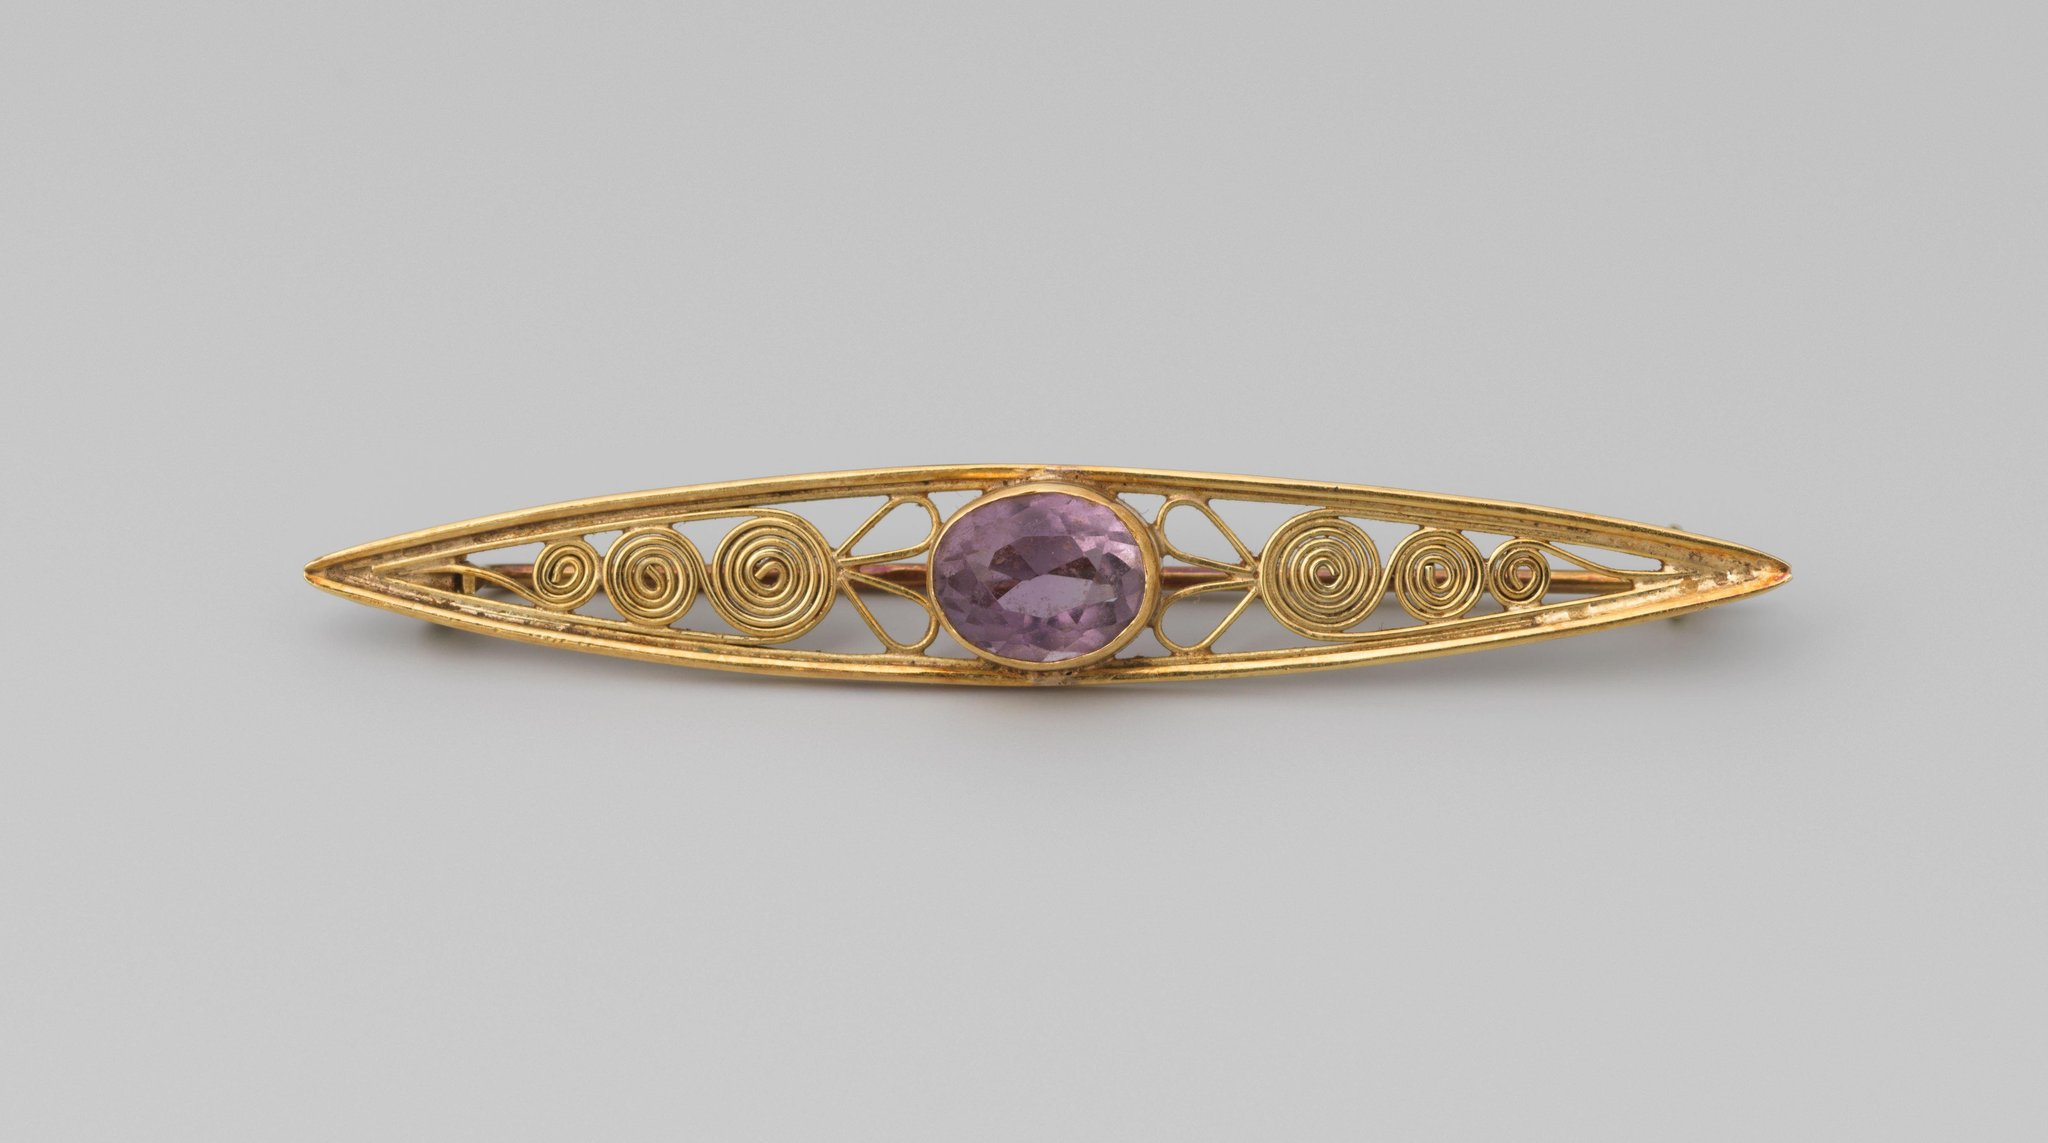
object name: brooch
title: Brochette van draadwerk in goud met amethist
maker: p.a. van der griend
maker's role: jeweler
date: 1943-1953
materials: gemstone, gold thread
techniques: faceting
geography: diemen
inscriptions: maker's mark: ‘P8G’, alloy mark: ‘(oud) eikenblad’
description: Brochette van draadwerk in goud met een ovaal gefacetteerde amethist.